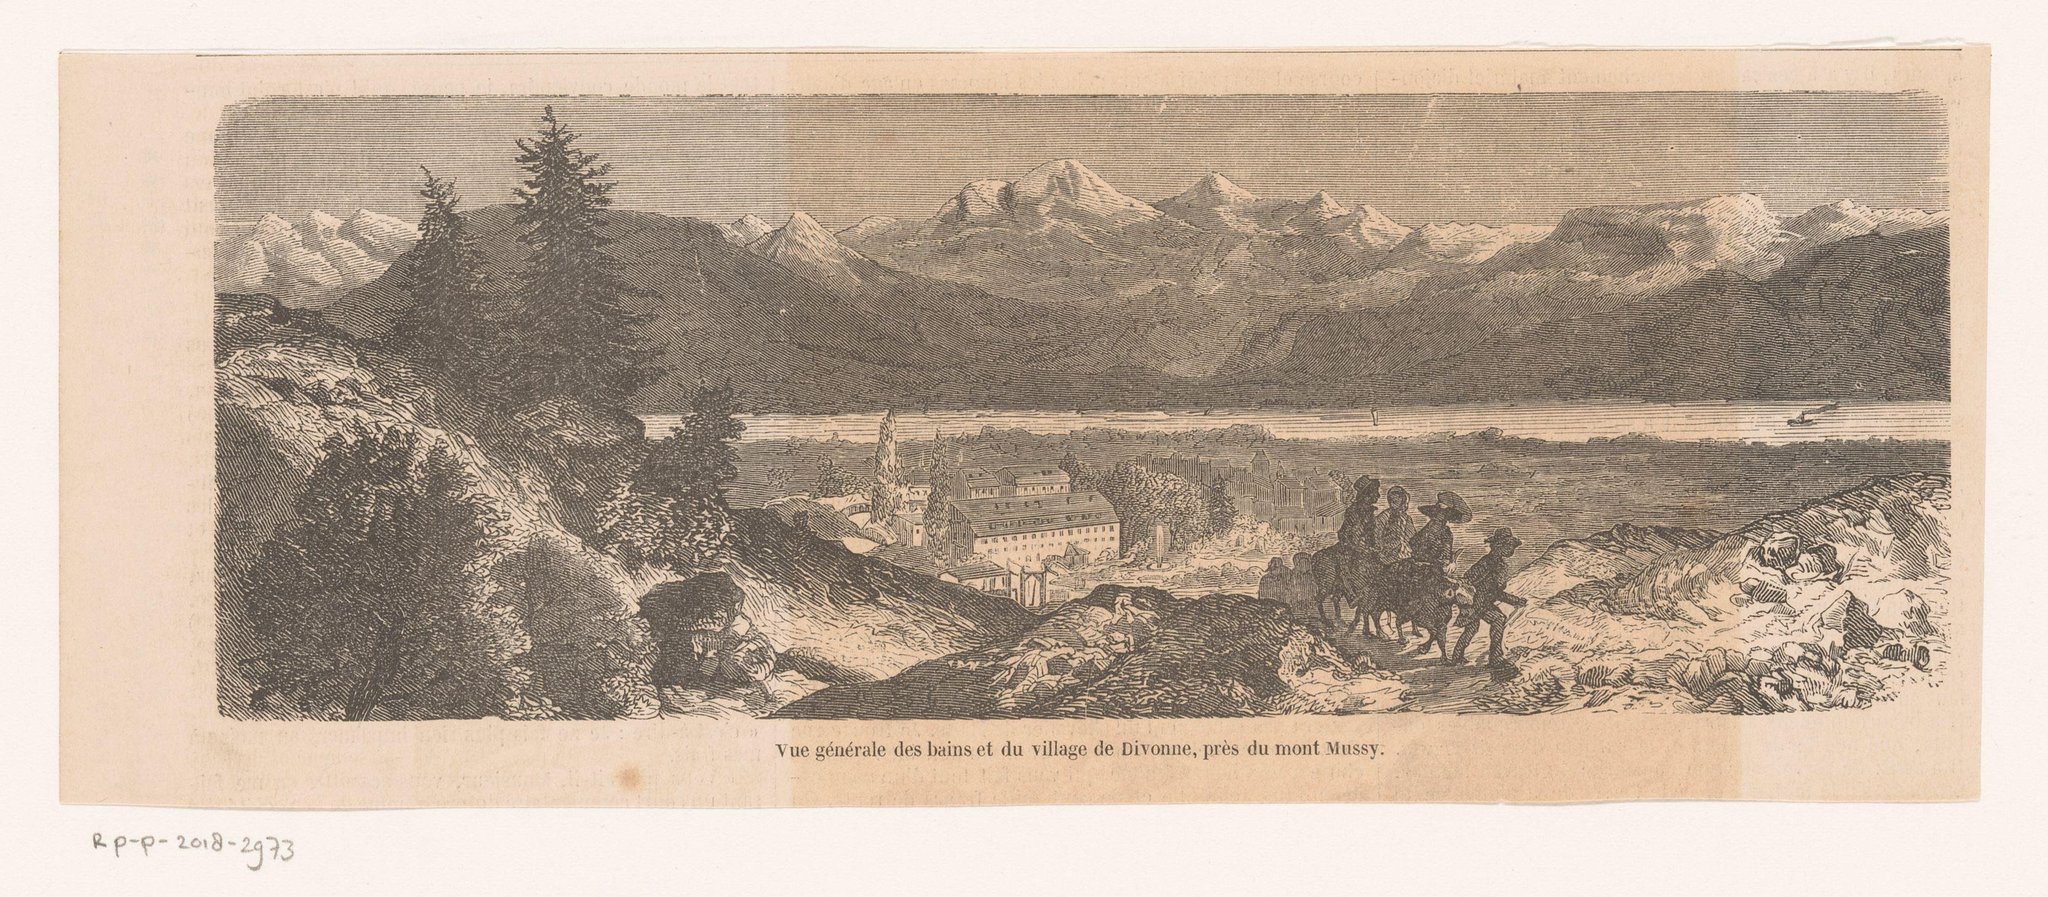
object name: print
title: Vue générale des bains et du village de Divonne, près du mont Mussy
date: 1856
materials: paper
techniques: letterpress printing, engraving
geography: paris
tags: prospect of village, silhouette of village, mountains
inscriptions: inscription: ‘L'Illustration 19 juli, 1856’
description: Gezicht op de baden en de plaats Divonne, nabij de berg Mussy.